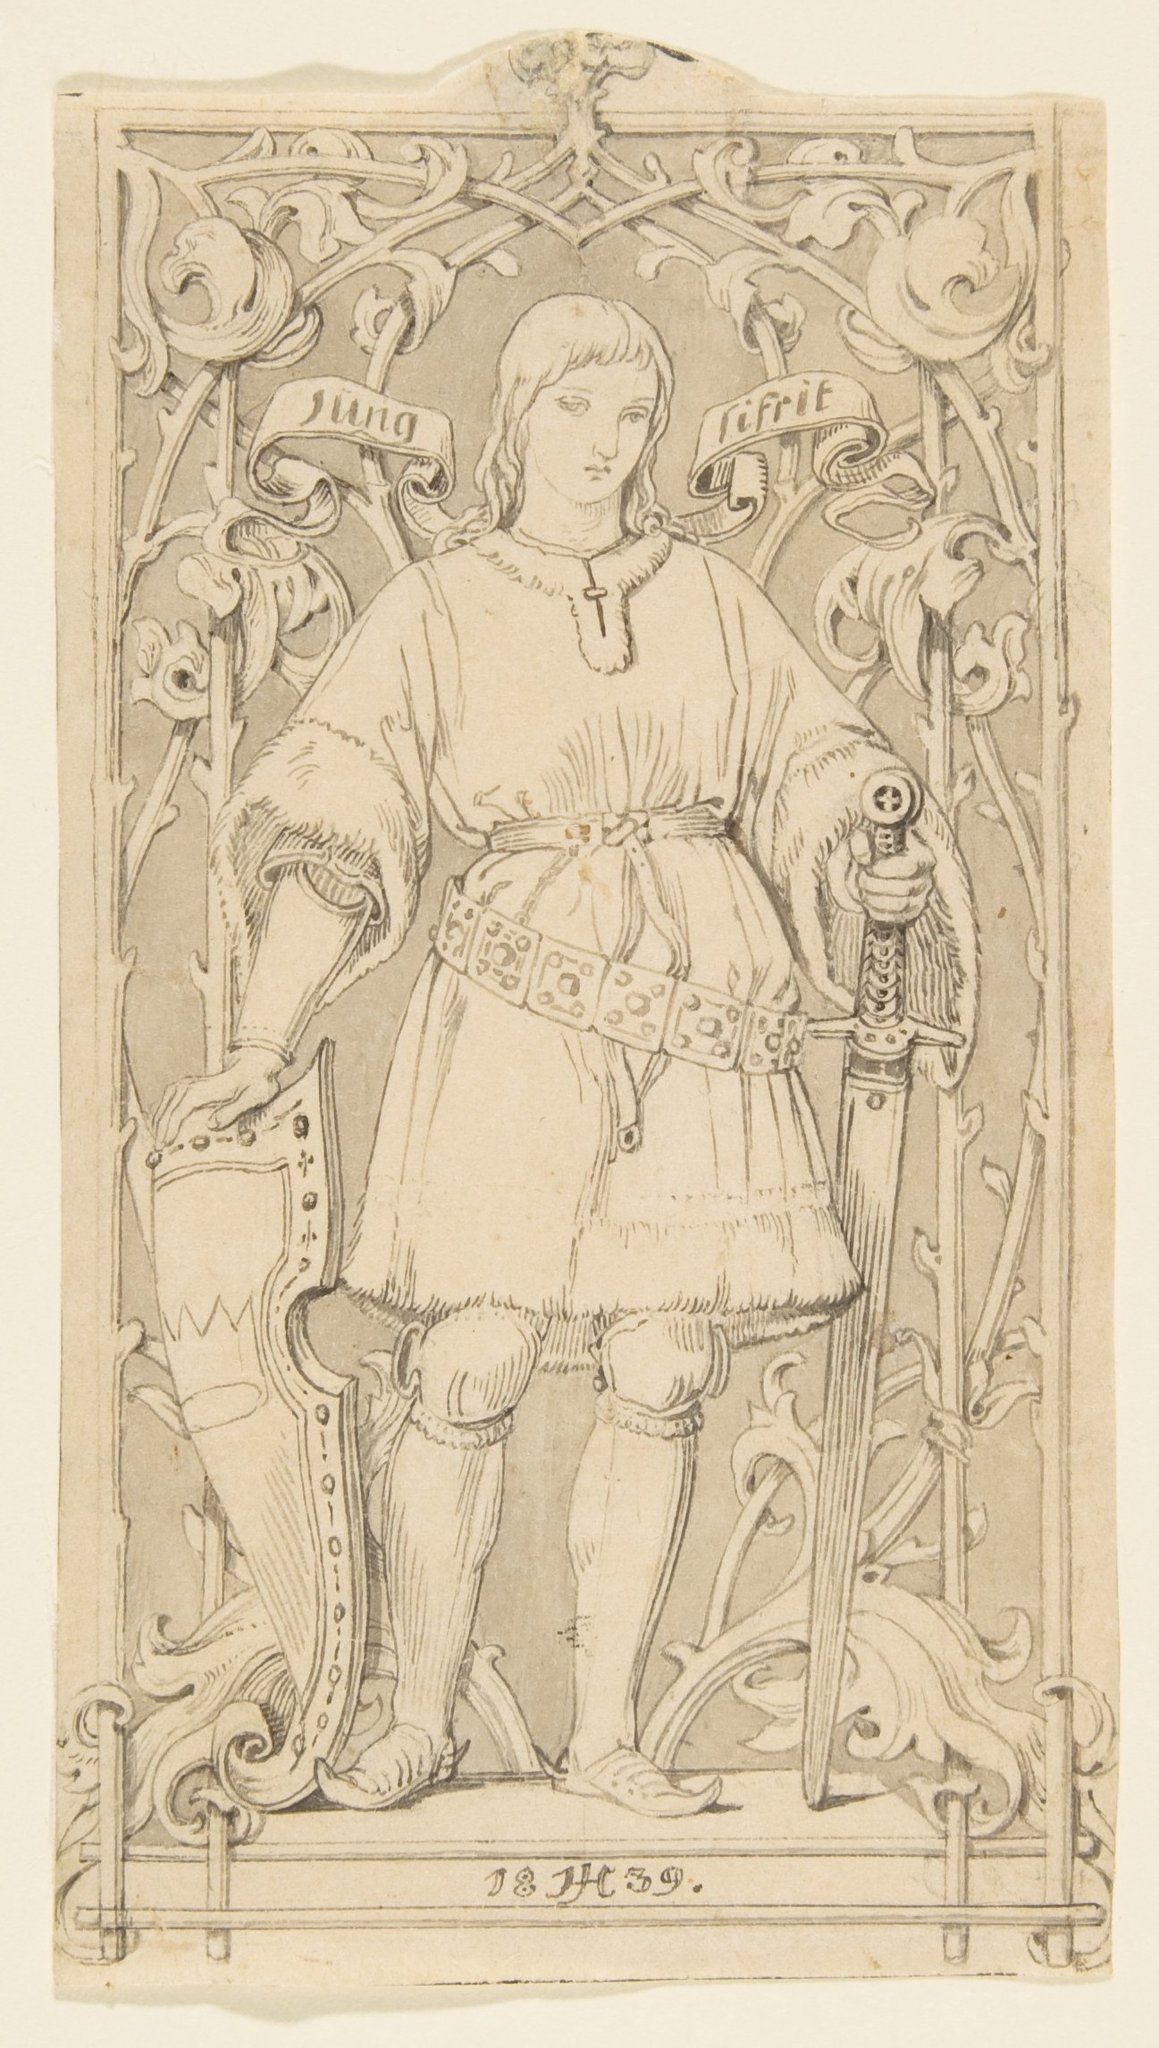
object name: drawing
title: The Young Siegfried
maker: julius hübner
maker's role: artist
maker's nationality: german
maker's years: 1806-1882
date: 1839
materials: ink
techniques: brush, pen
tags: shields,swords,men,norse mythology